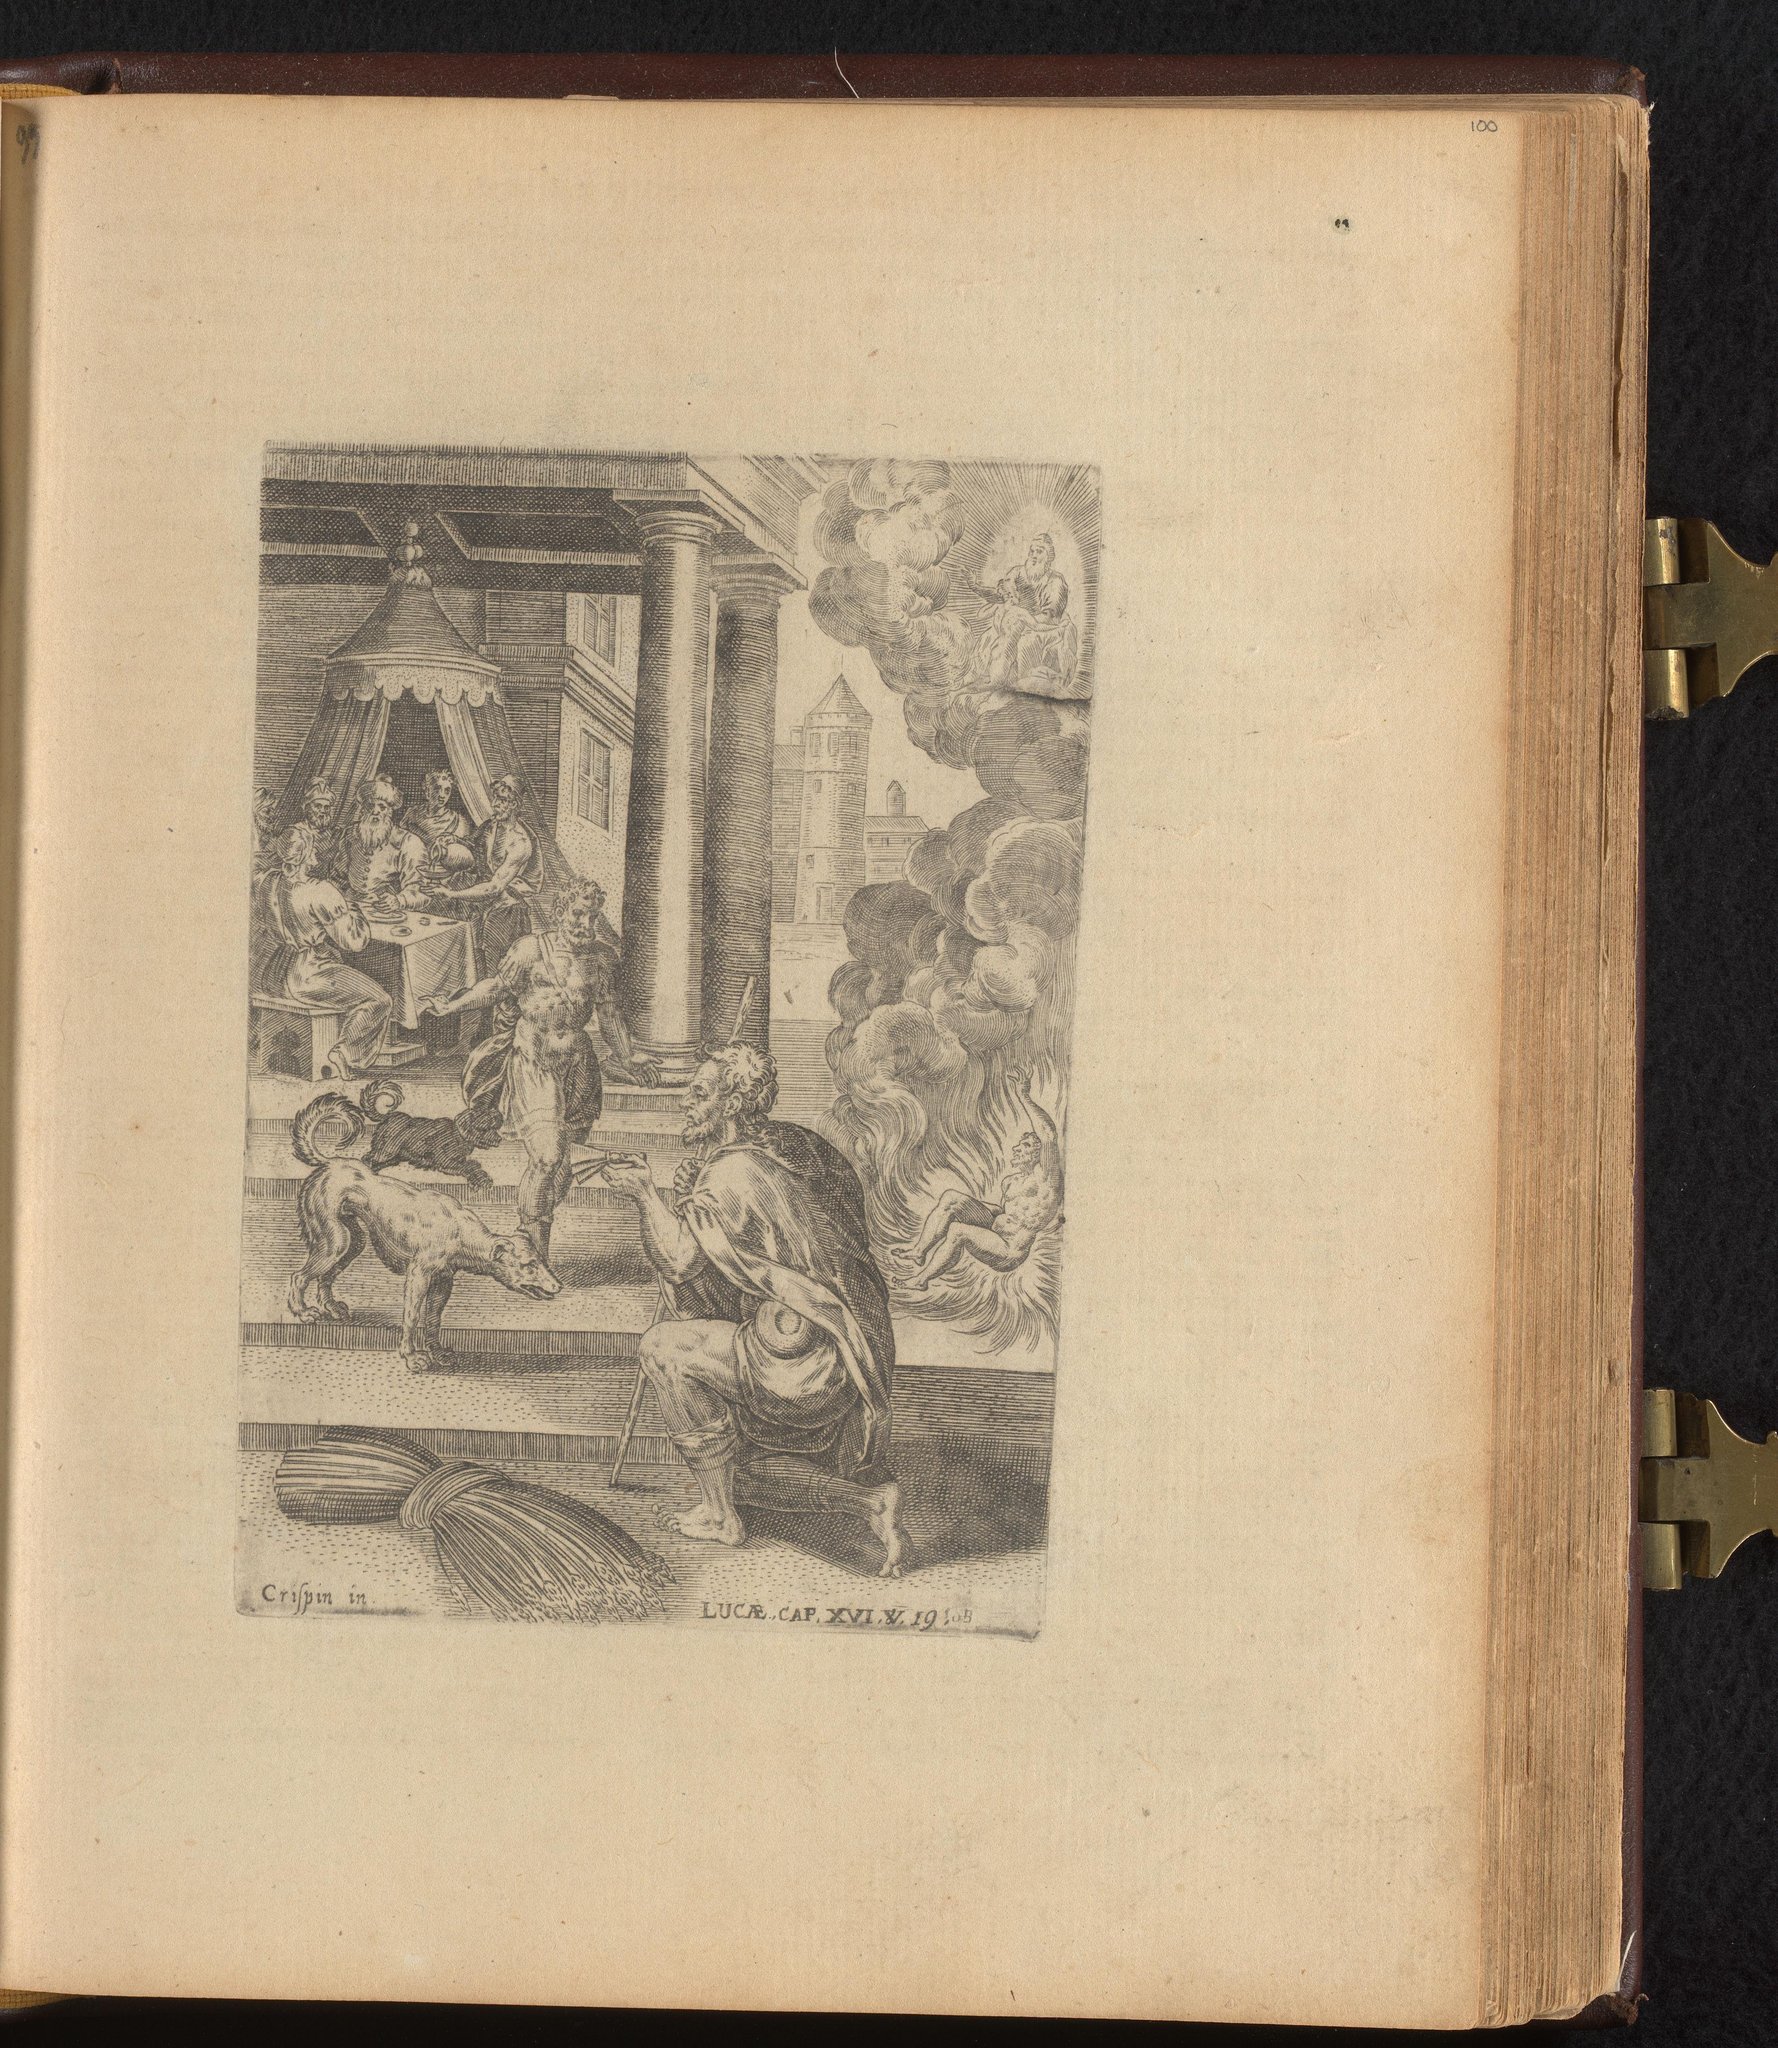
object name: album leaf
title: Parabel van Lazarus en de rijke man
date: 1583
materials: paper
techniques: engraving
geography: antwerp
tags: in hell dives sees lazarus in paradise; usually dives pointing at his tongue, lazarus' soul in abraham's bosom, the rich man (dives) is feasting, while poor lazarus is starving at the gate (dogs licking lazarus' sores) (luke 16:19-31)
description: Eerdere staat van prent gebruikt als boekillustratie in: Biblia Sacra. Antwerpen: Christoffel Plantijn, 1583.